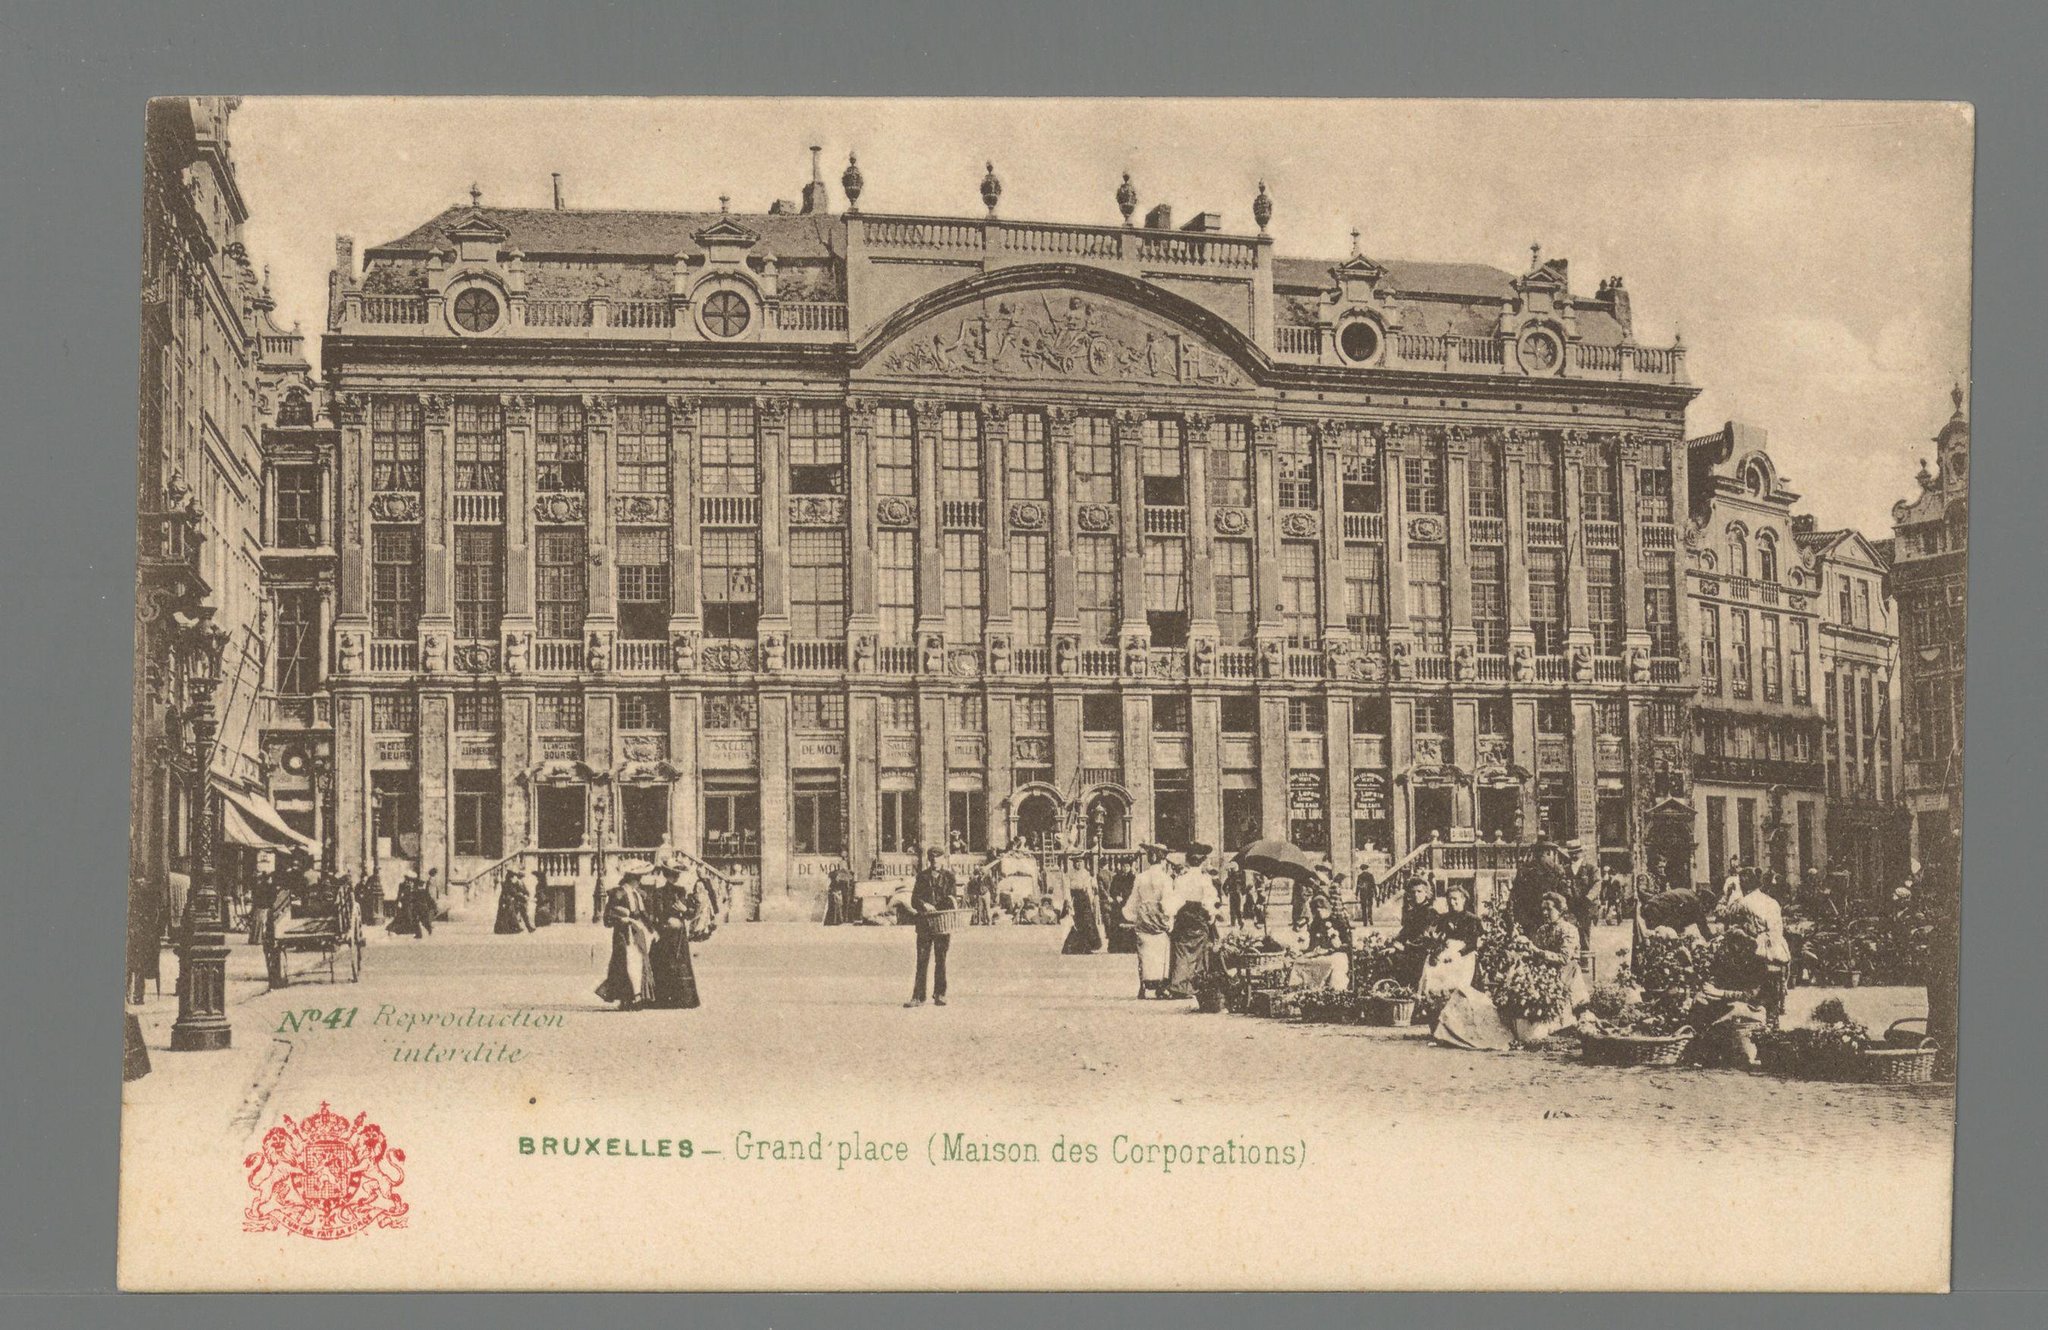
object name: ansichtkaart, prentbriefkaart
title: Bruxelles. Grand'place (Maisons des Corporations)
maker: Anonymous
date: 1903-1906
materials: cardboard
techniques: photograph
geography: brussels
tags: square, place, circus, etc., market, city-view, and landscape with man-made constructions (+ city(-scape) with figures, staffage)